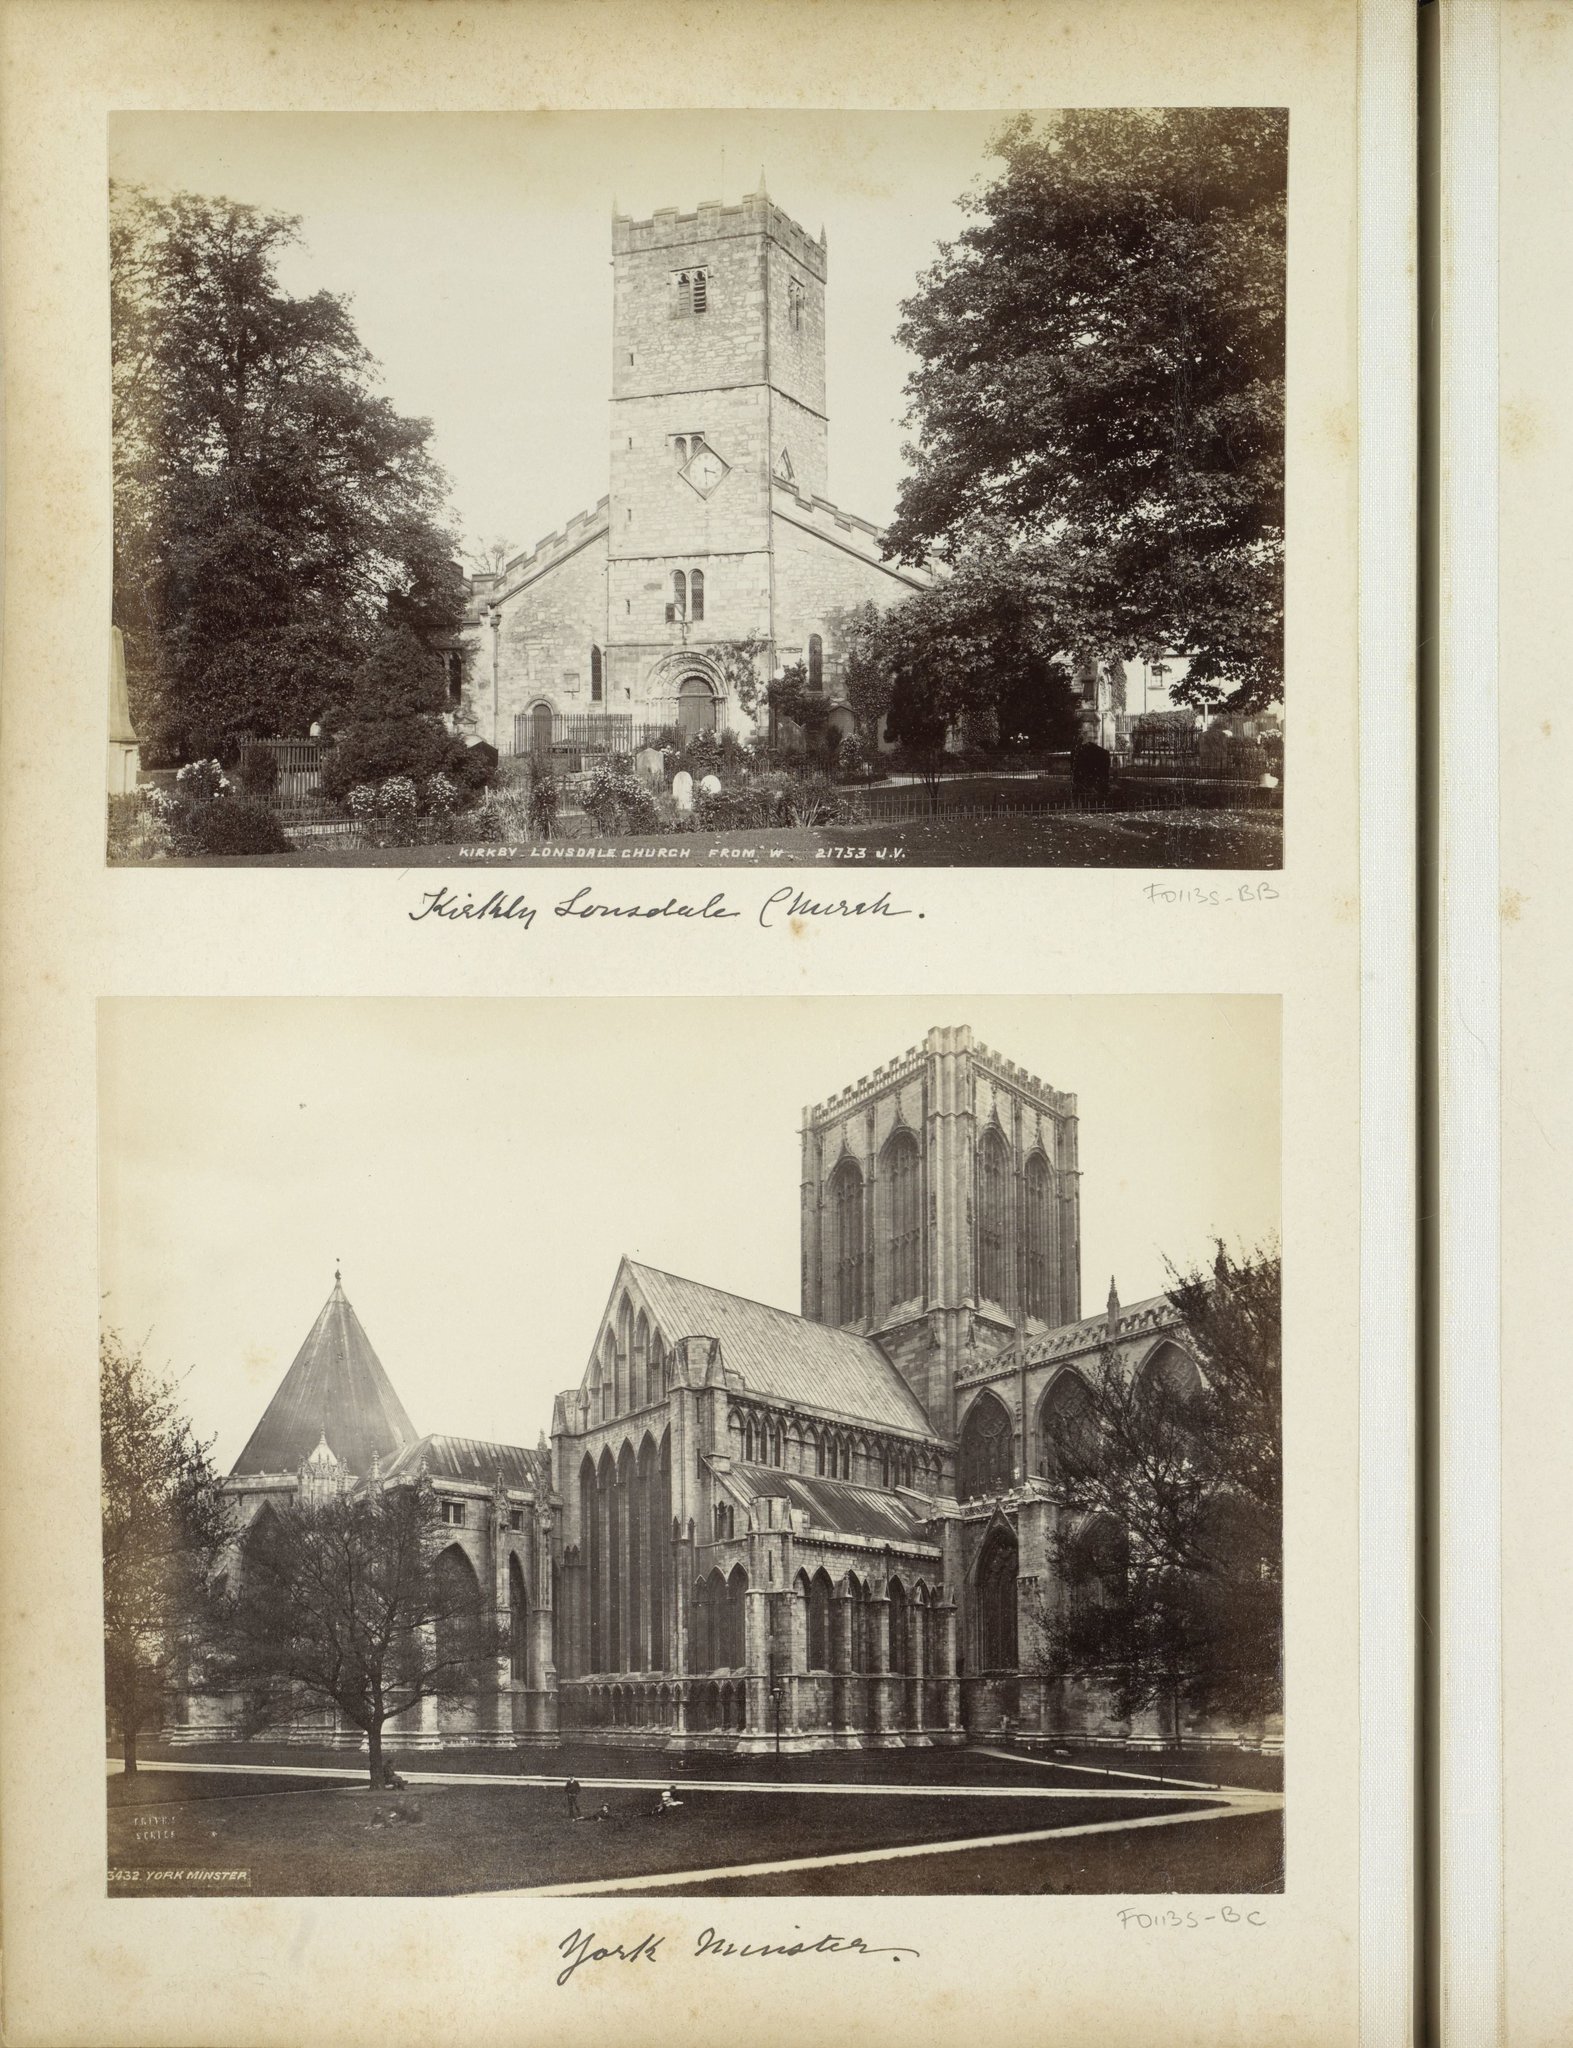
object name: photograph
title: Exterieur van Kirkby Lonsdale Church, met op de voorgrond grafstenen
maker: james valentine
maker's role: fotograaf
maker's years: 1815-1880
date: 1899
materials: paper, photographic support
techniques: albumen print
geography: kirkby lonsdale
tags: church (exterior), churchyard, cemetery, parts of church exterior and annexes: tower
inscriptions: negative number: ‘21753’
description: Onderdeel van Reisalbum met foto's van bezienswaardigheden in Engeland en Frankrijk.